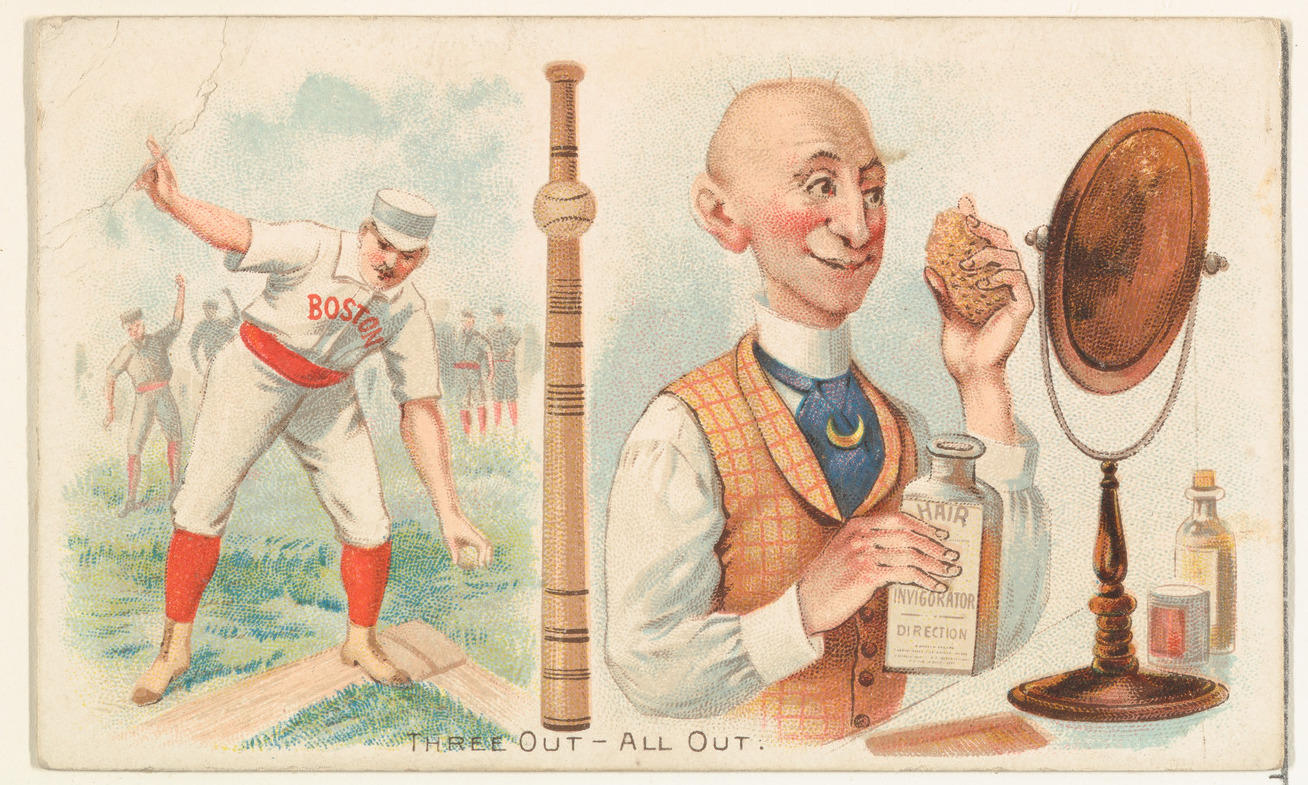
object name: print, baseball card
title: Out- All Out, from the Talk of the Diamond set (N135) issued by Duke Sons & Co., a branch of the American Tobacco Company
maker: w. duke, sons & co.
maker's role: publisher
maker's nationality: american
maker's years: 1870-1920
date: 1888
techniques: color lithograph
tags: men,baseball